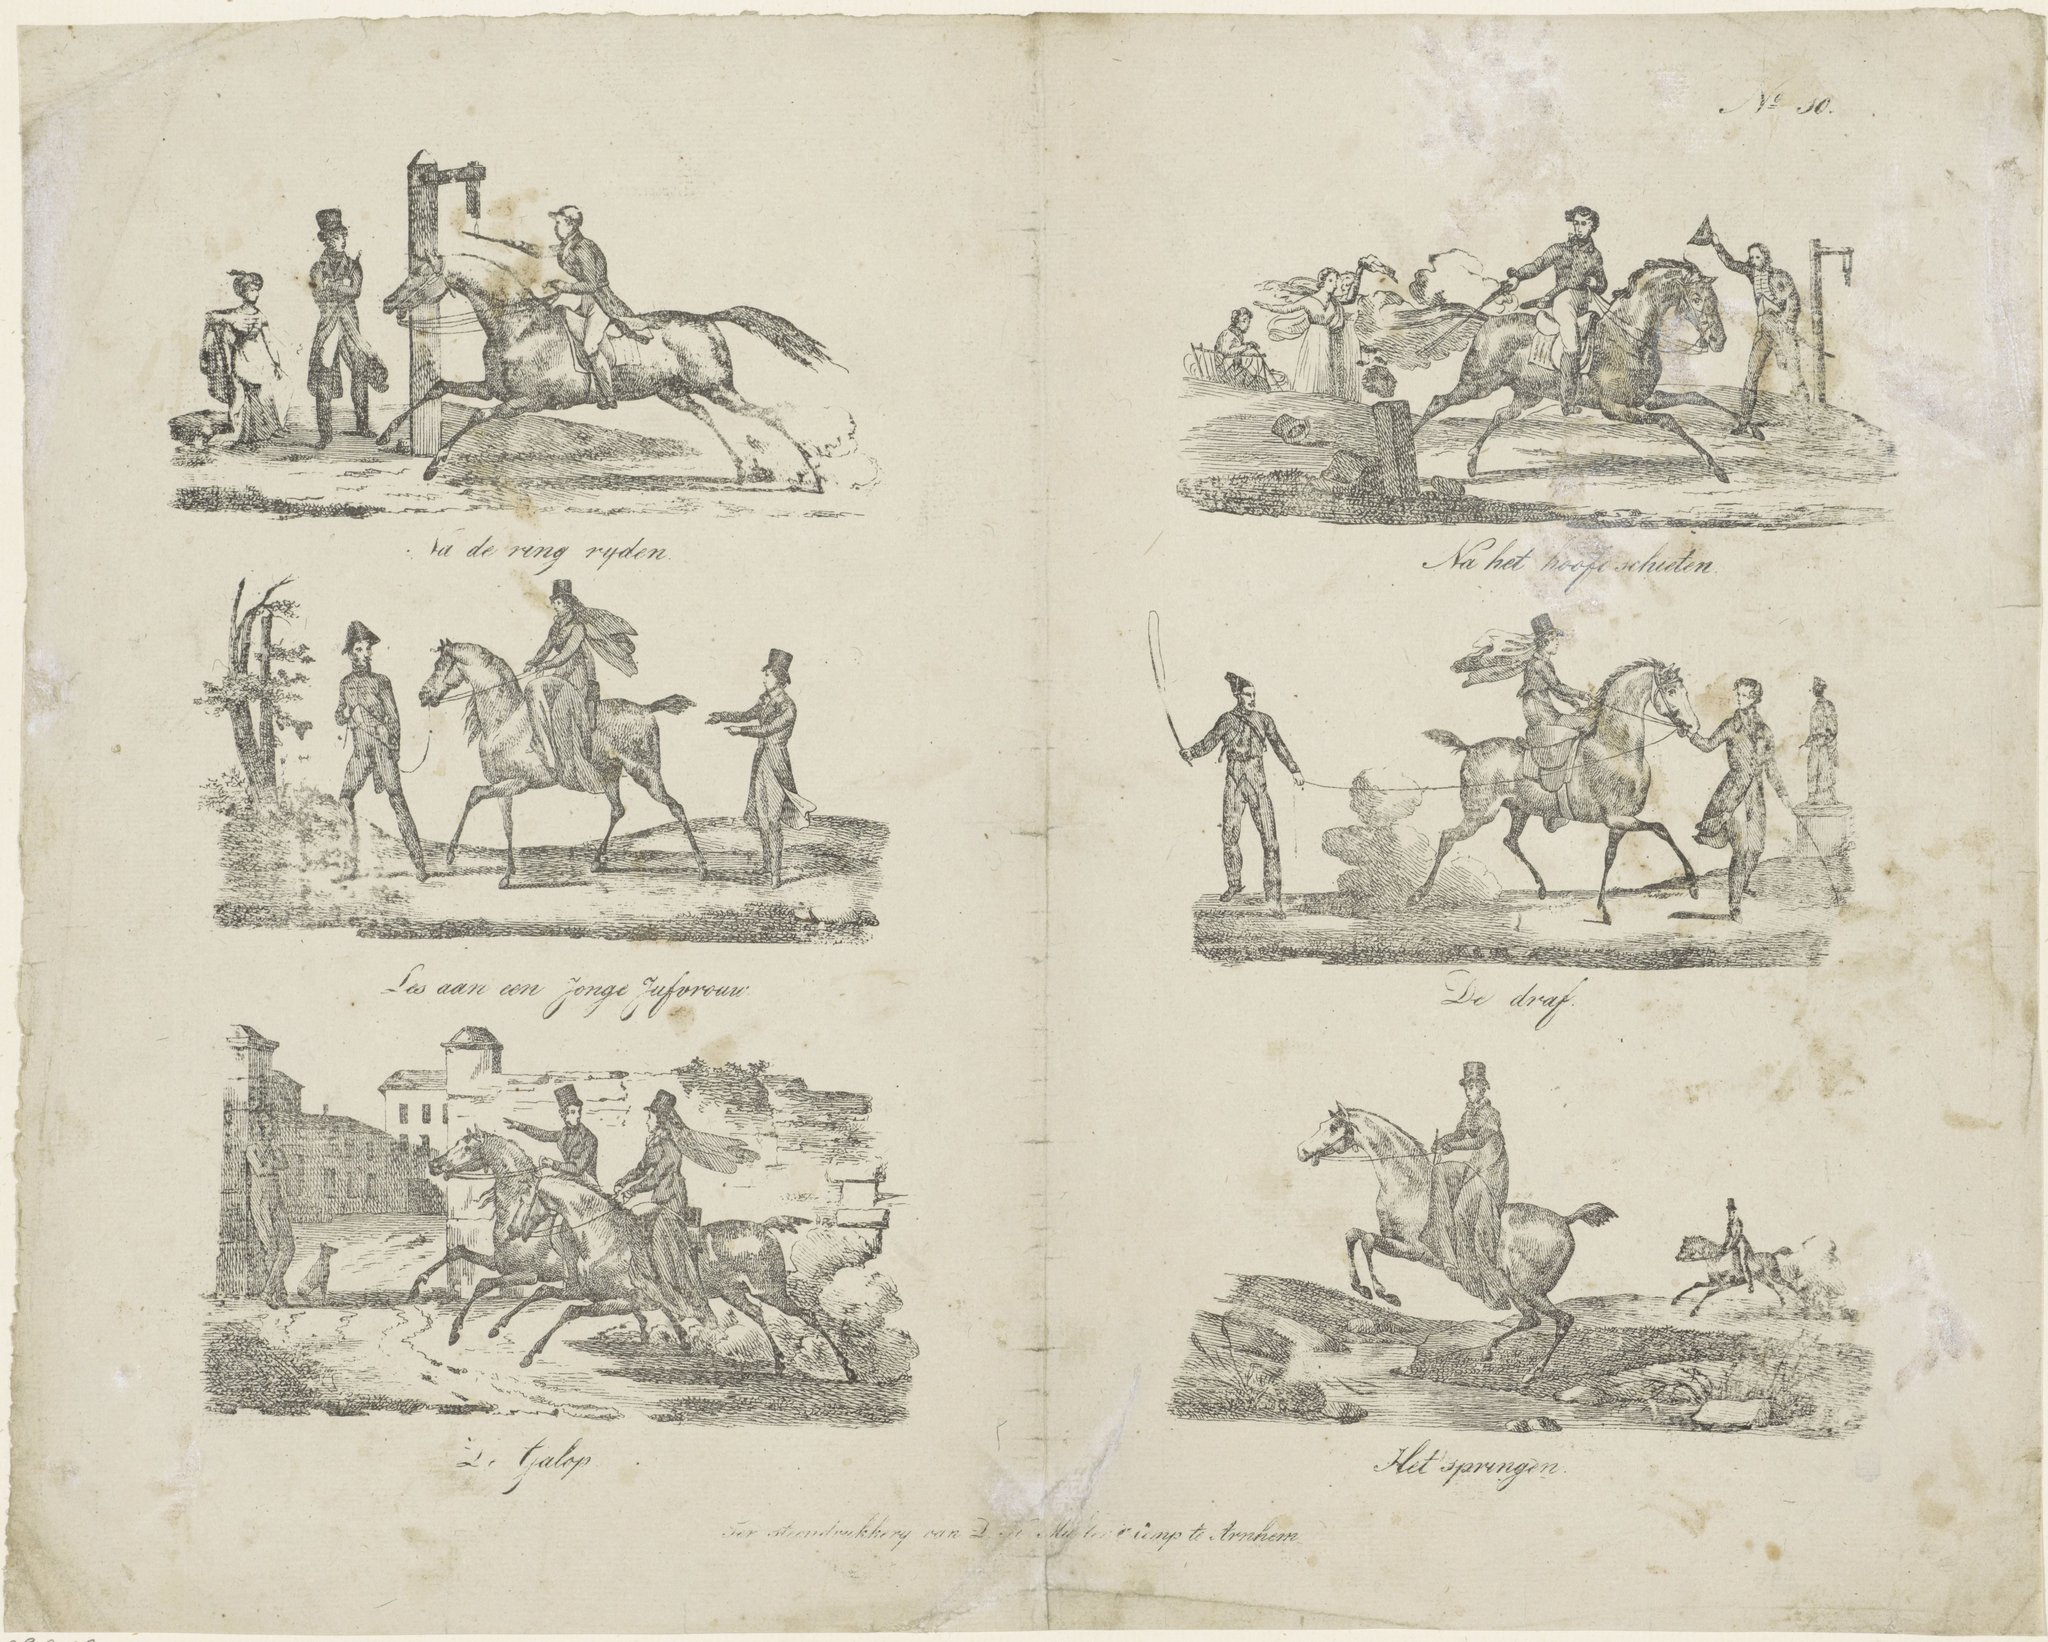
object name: print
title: Paardrijden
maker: Anonymous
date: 1815-1842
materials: paper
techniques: lithograph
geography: arnhem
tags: riding a horse, ass, or mule; rider, horseman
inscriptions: collector's mark: Lugt 2760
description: Blad met 6 voorstellingen van ruiters te paard. Onder elke afbeelding een onderschrift. Genummerd rechtsboven: No. 10.